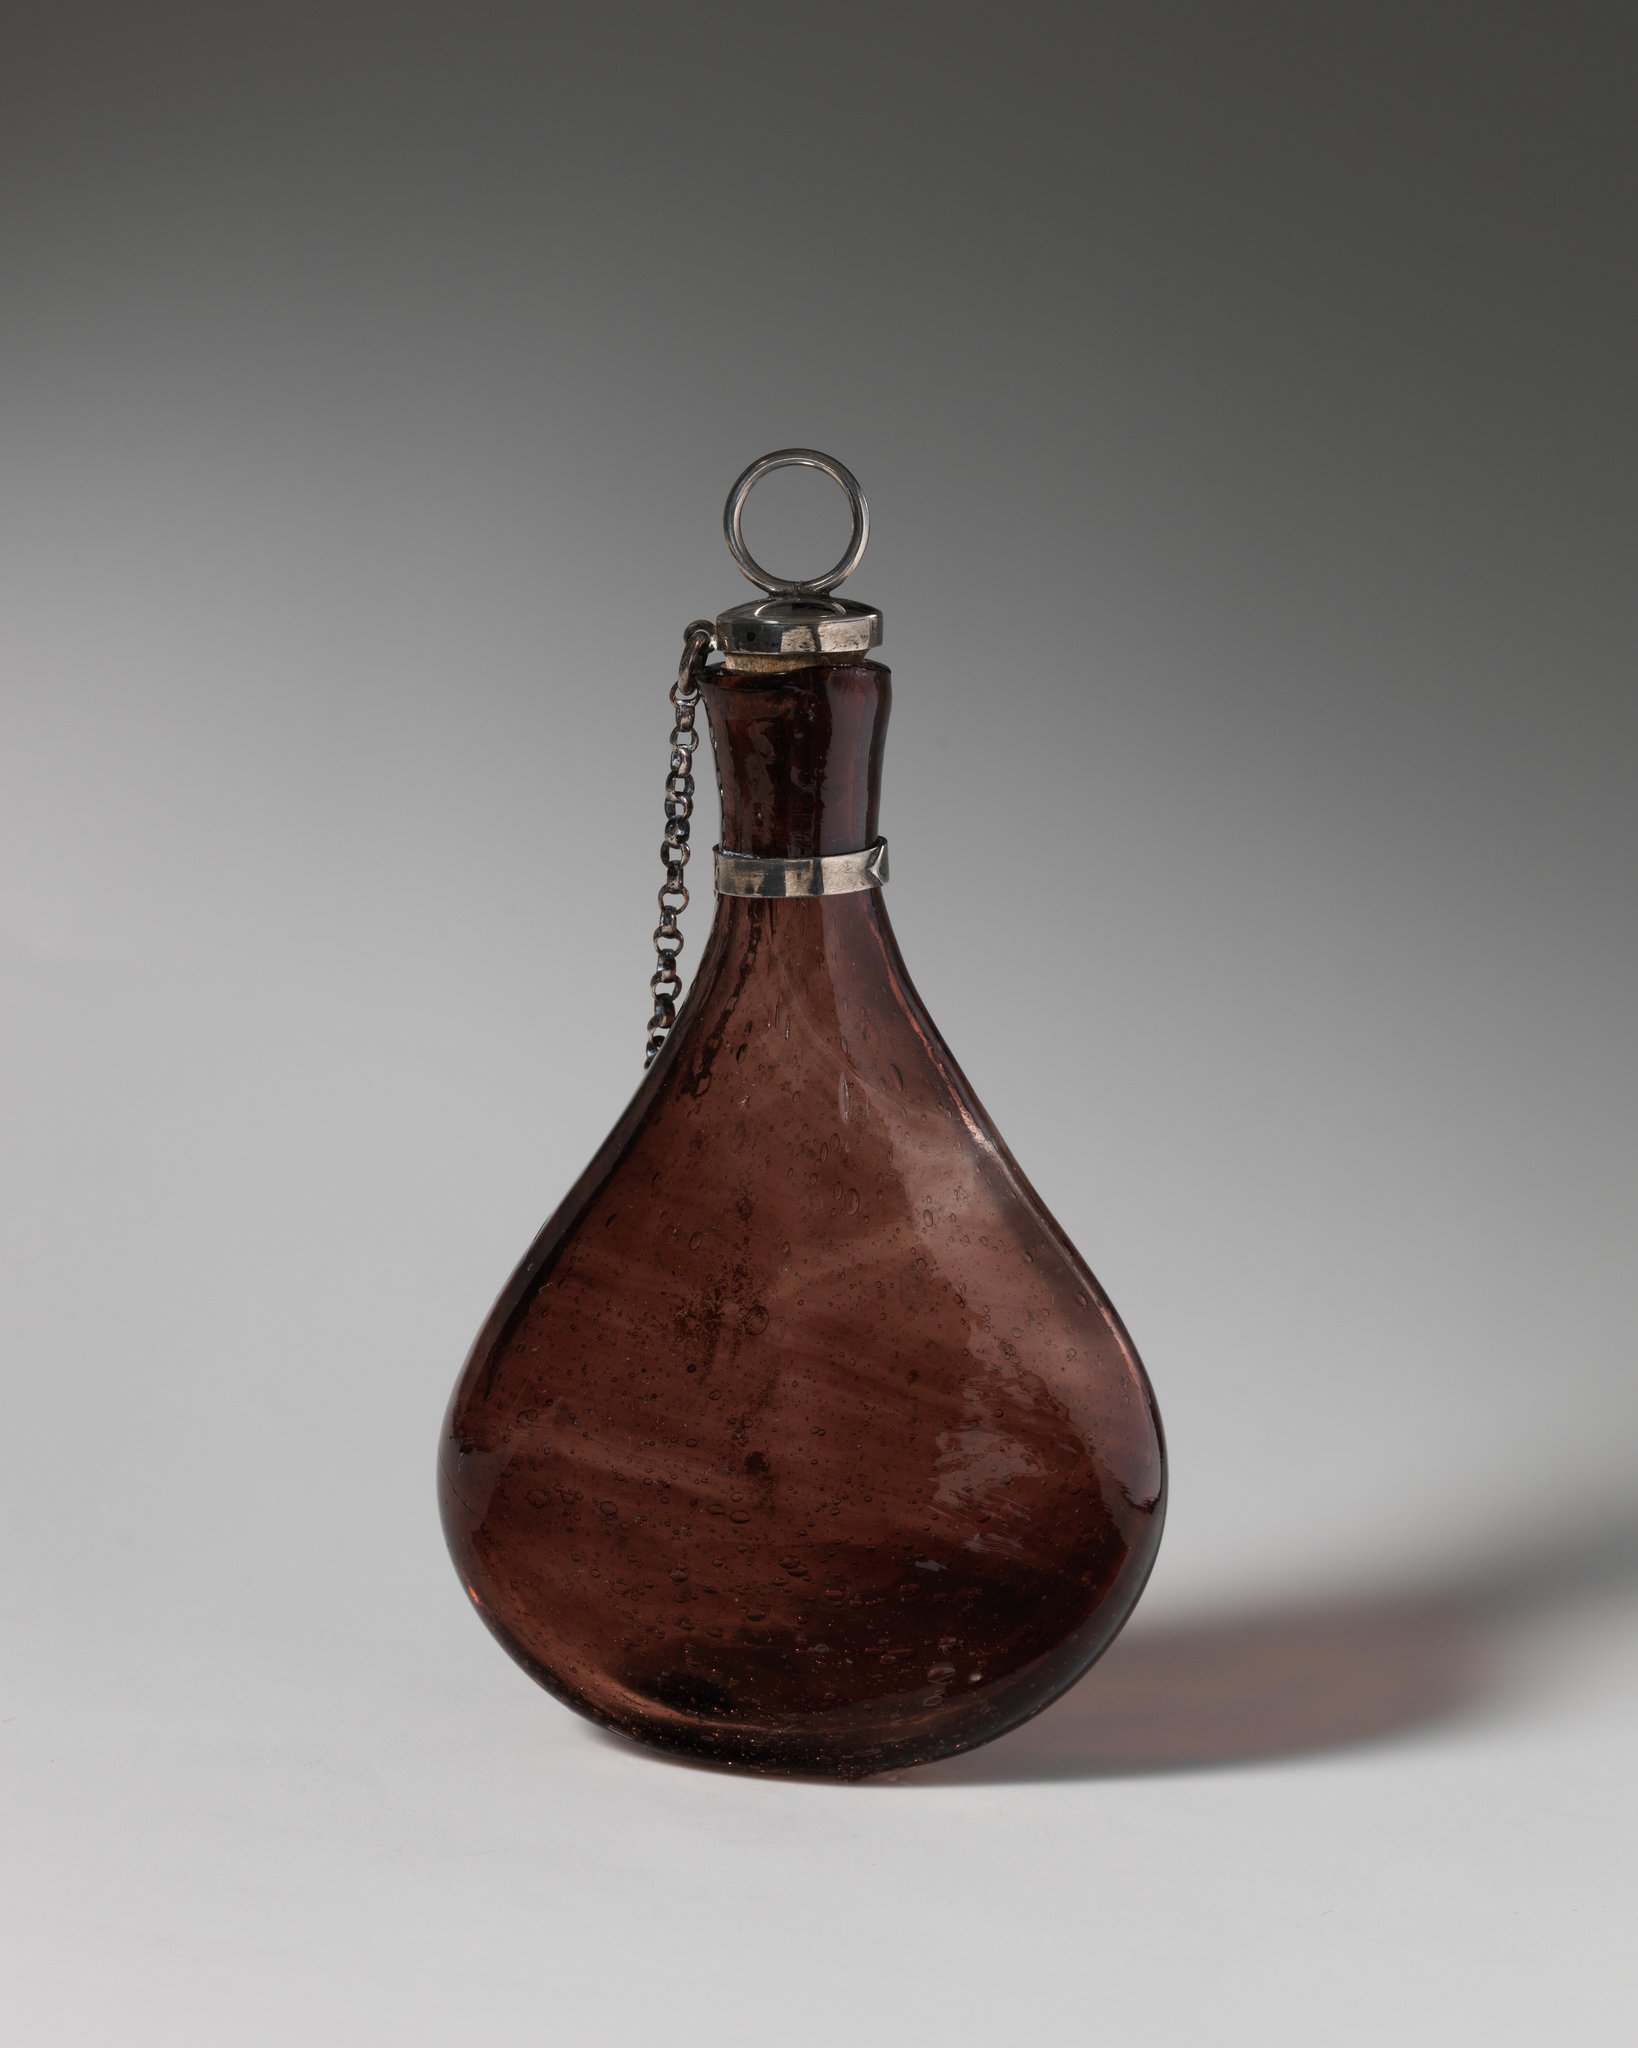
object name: bottle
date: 1701-1800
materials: glass